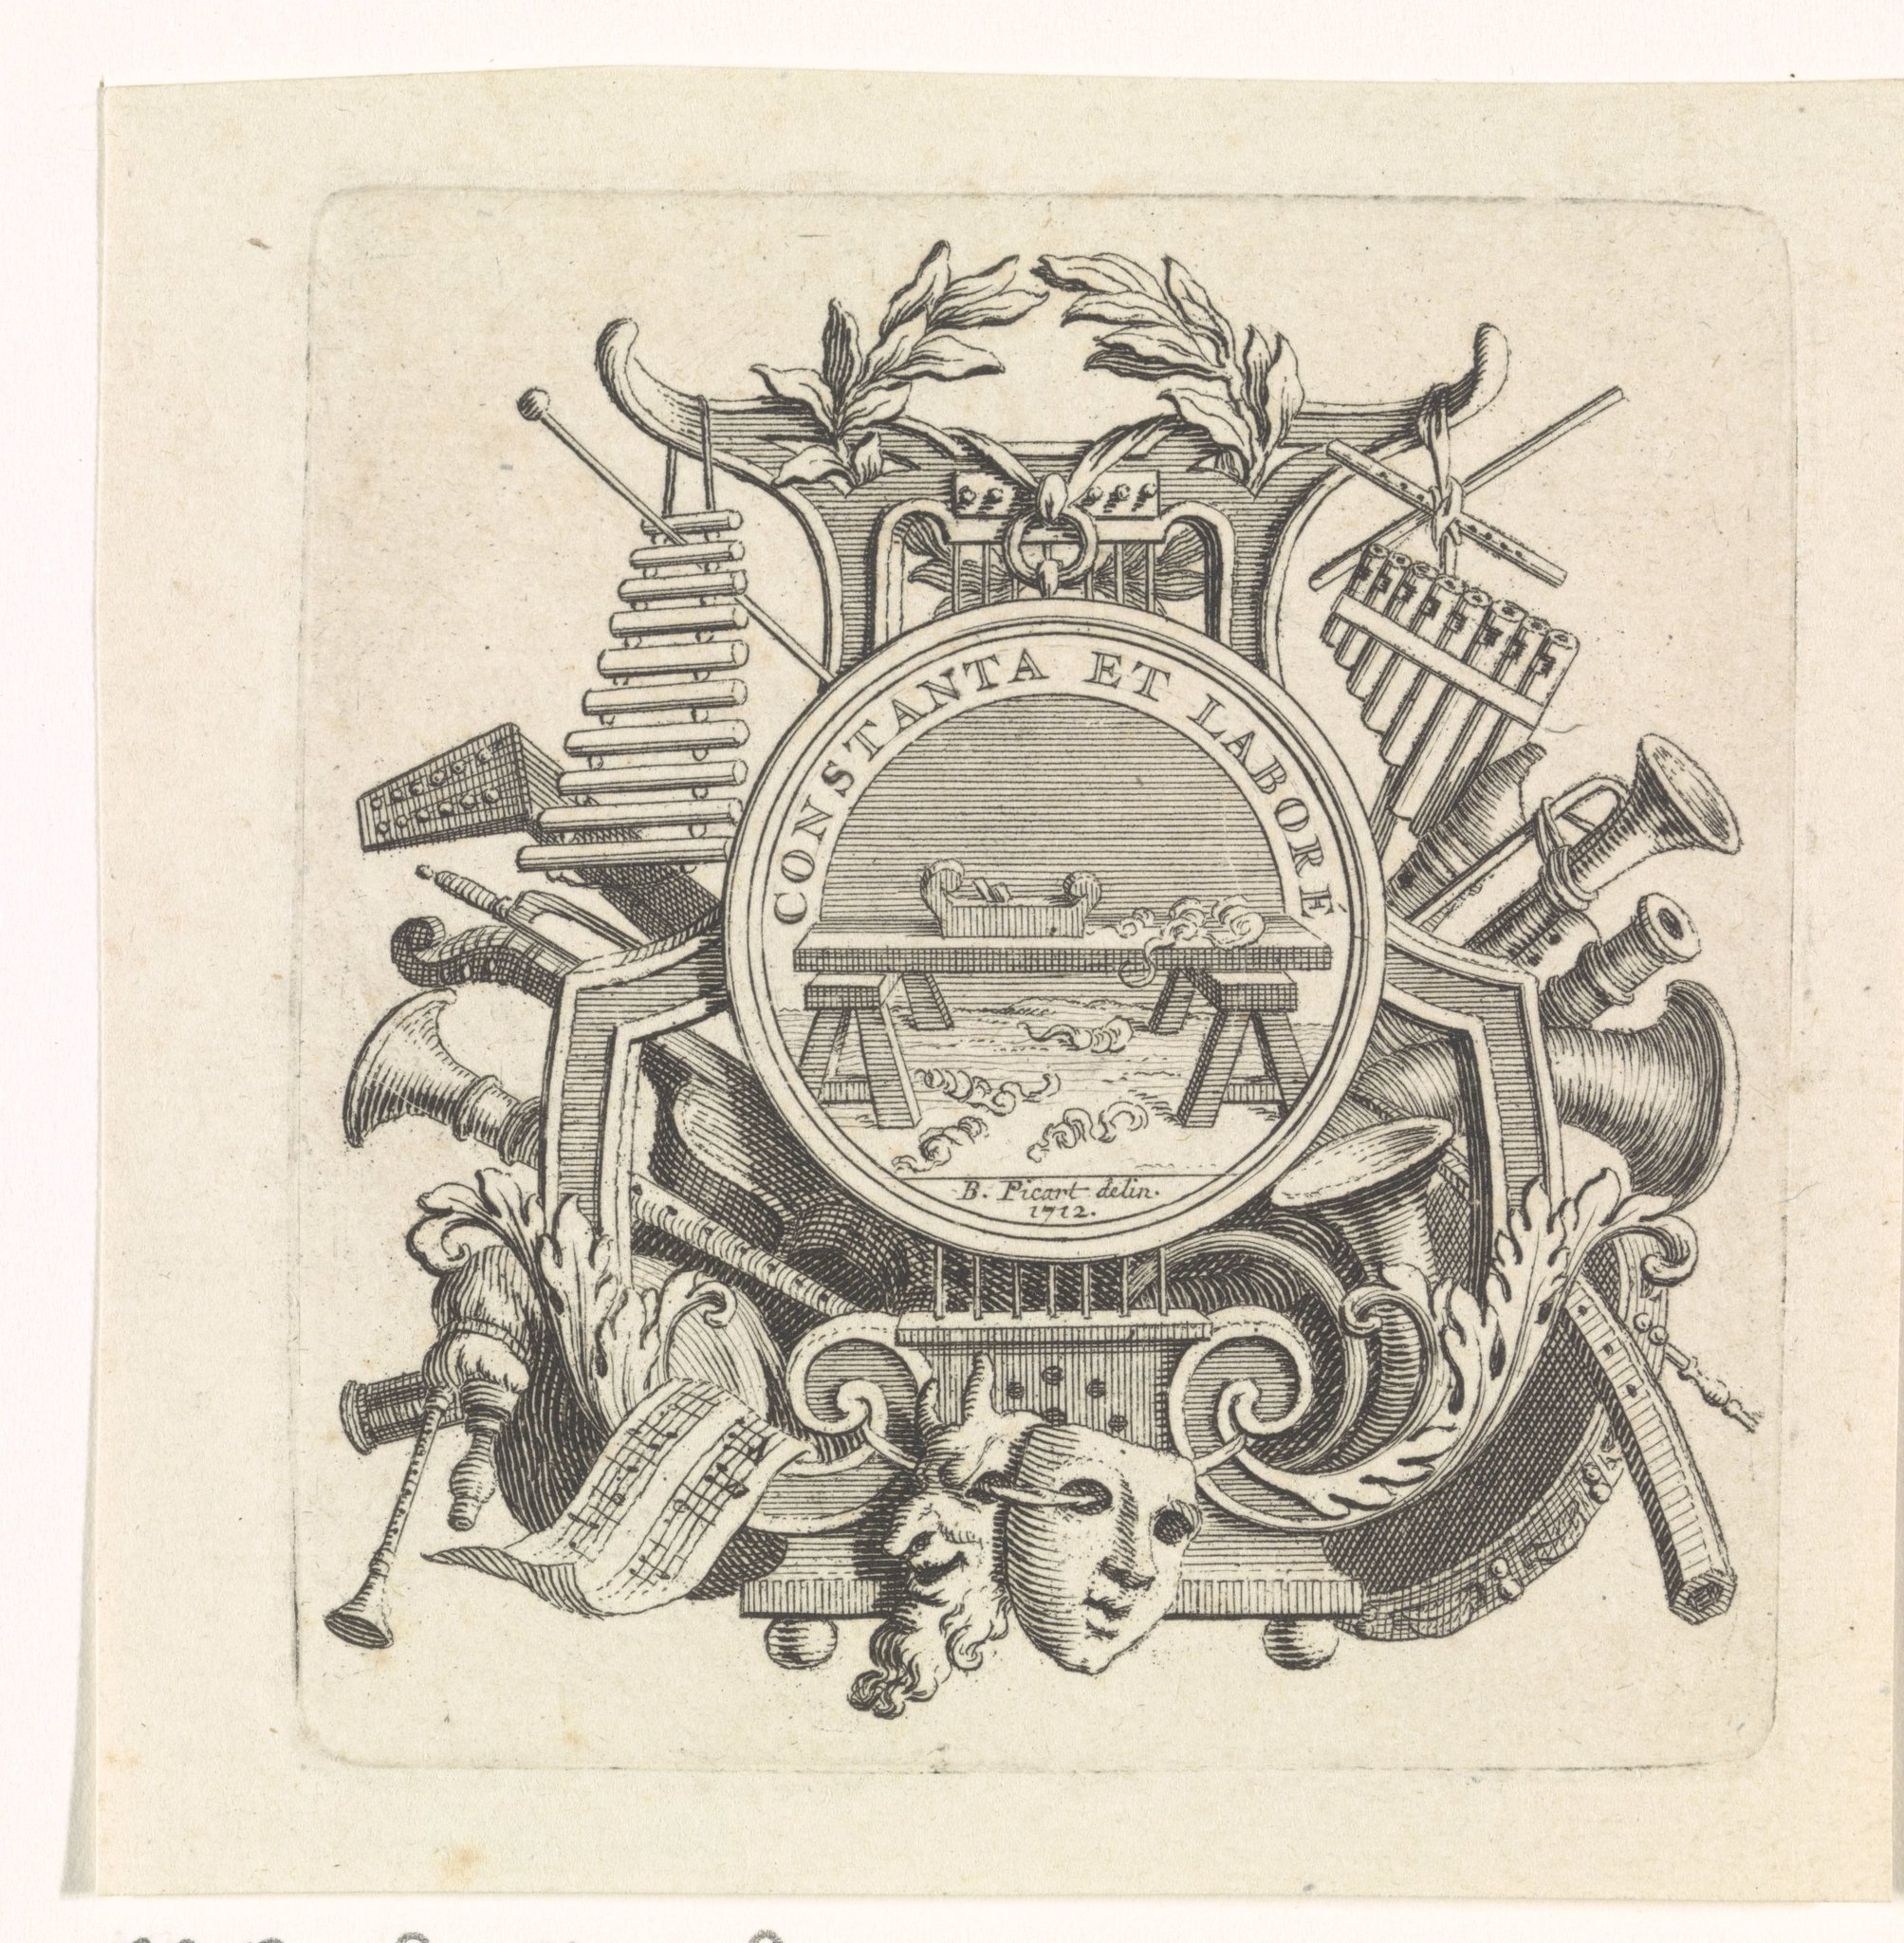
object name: print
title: Penning met een werkbank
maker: bernard picart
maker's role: draughtsman, print maker, publisher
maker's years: 1673-1733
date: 1712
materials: paper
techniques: engraving, etching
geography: amsterdam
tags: ornaments ~ art, other handicrafts ~ wood (+ materials processed ~ crafts, industries, agriculture)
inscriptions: collector's mark: Lugt 2228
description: Penning met de voorstelling van een werkbank en houtkrullen en het devies: Constanta et Labore. Rond de penning muziekinstrumenten, een masker en een lauwerkrans.